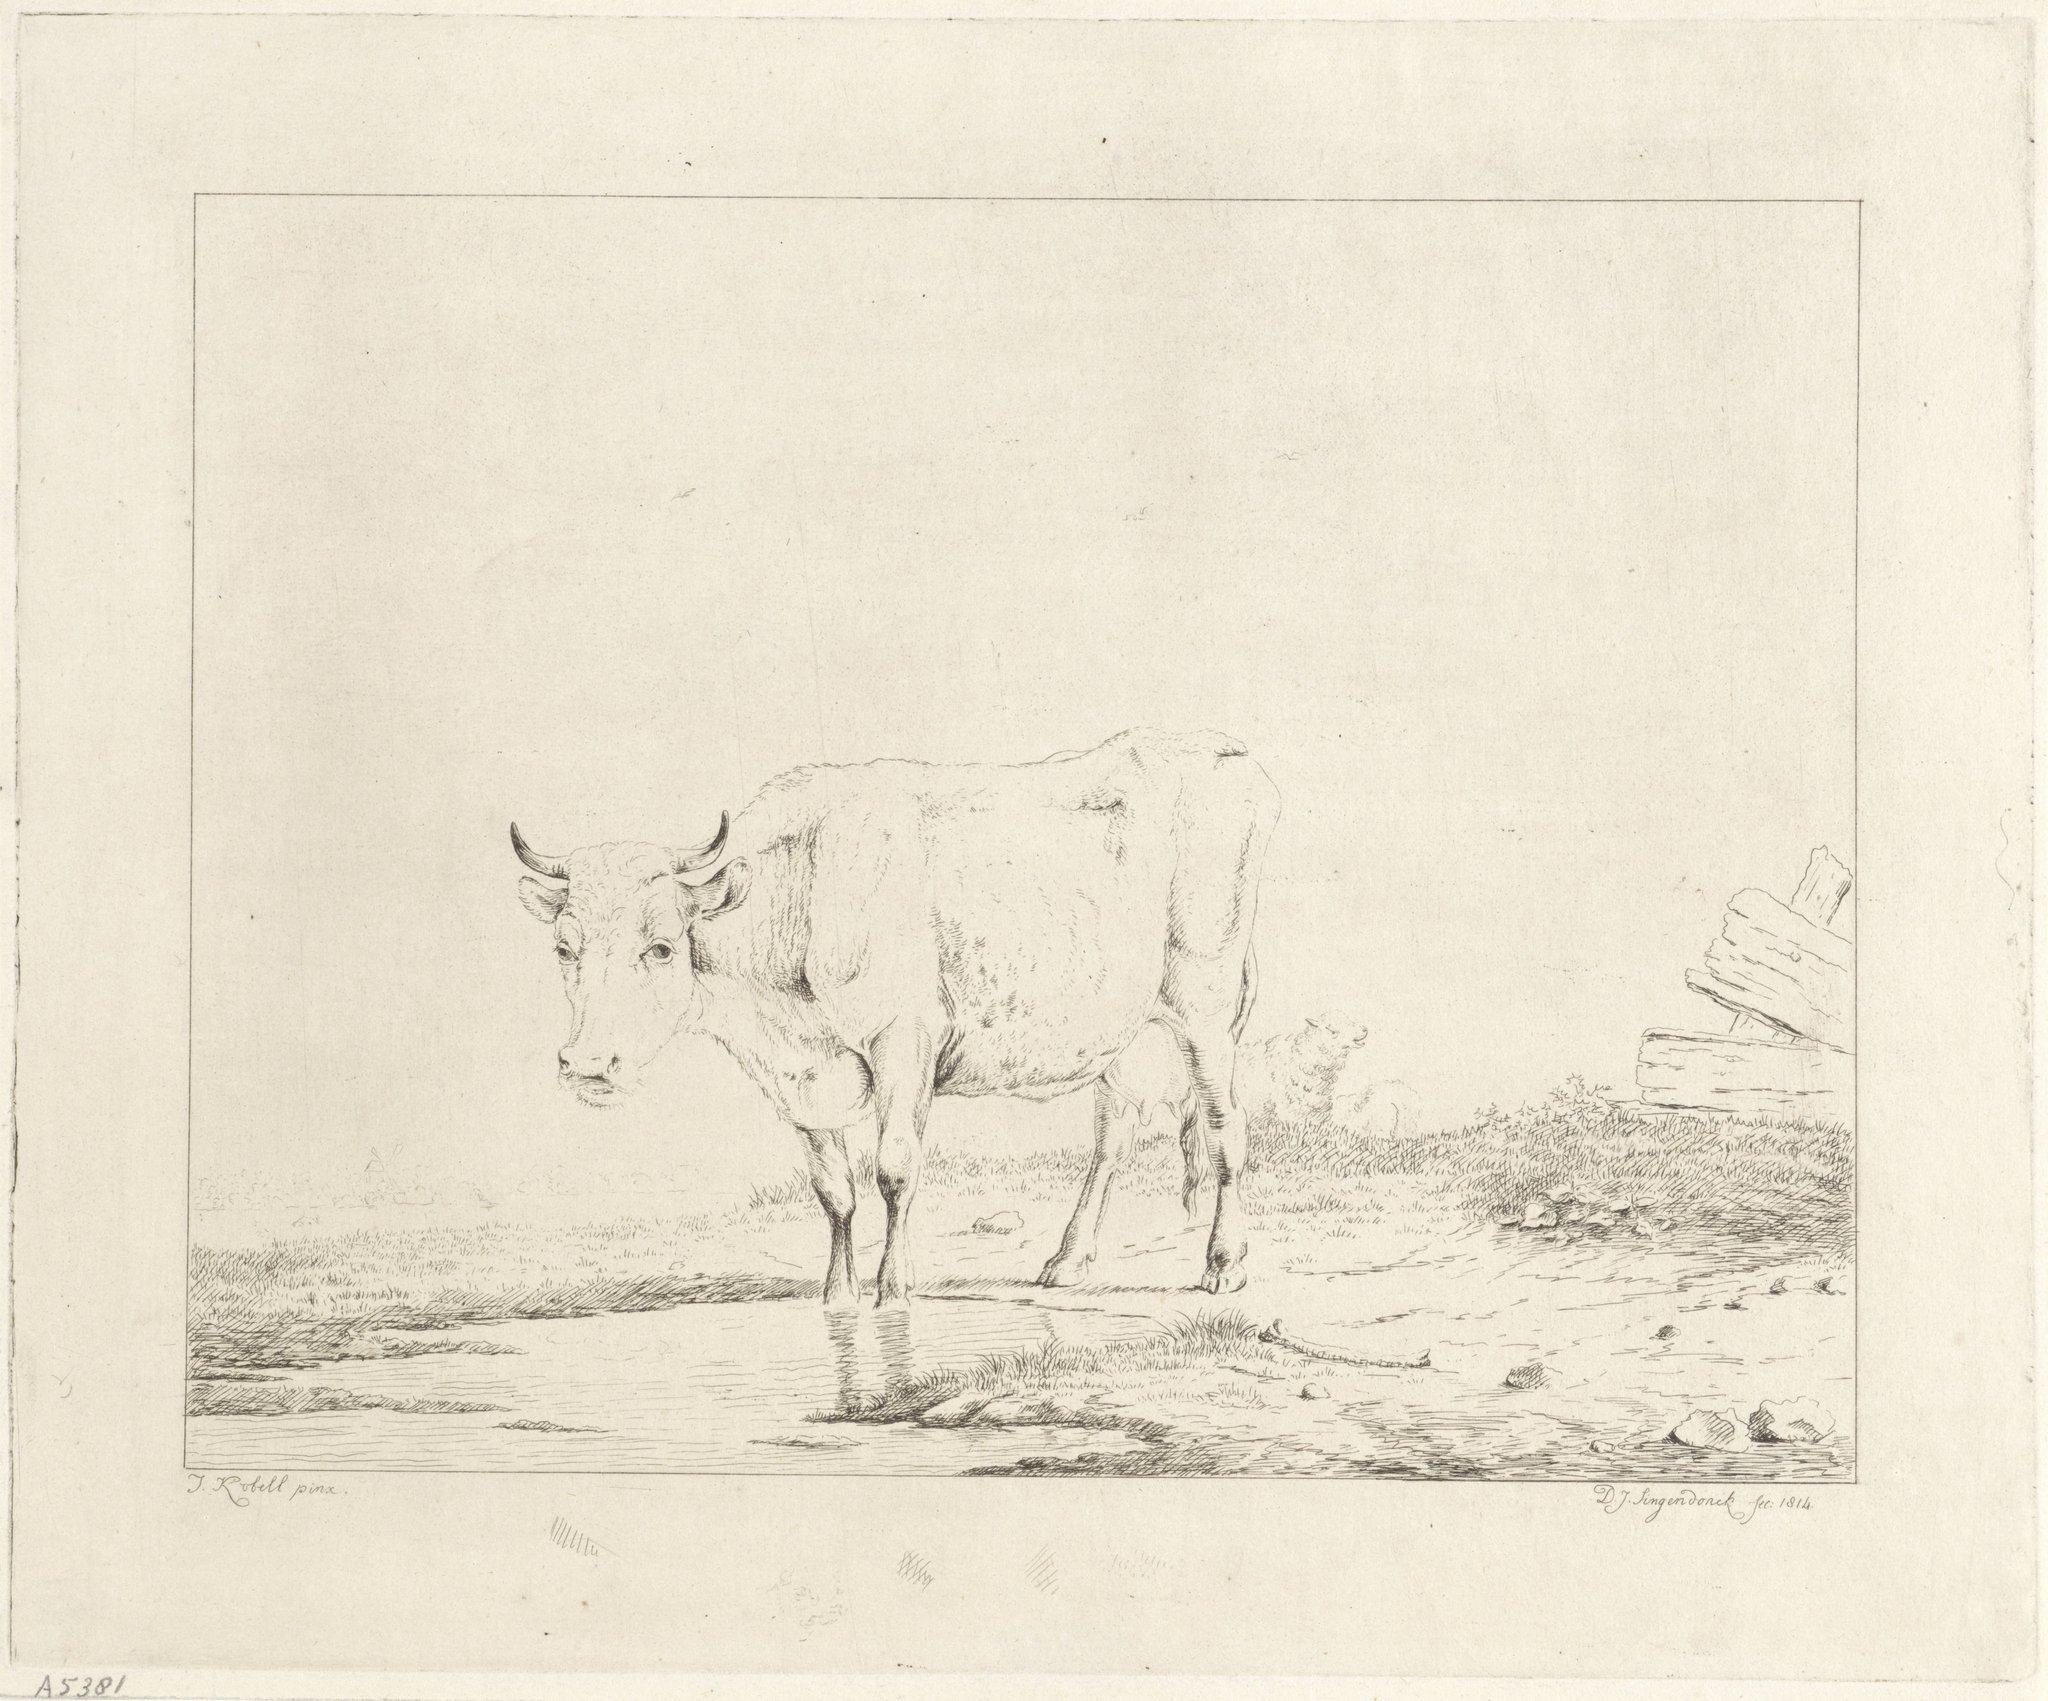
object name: print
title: Drinkende koe aan het water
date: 1814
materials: paper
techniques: etching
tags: cow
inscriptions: collector's mark: Lugt 514, collector's mark: Lugt 2228